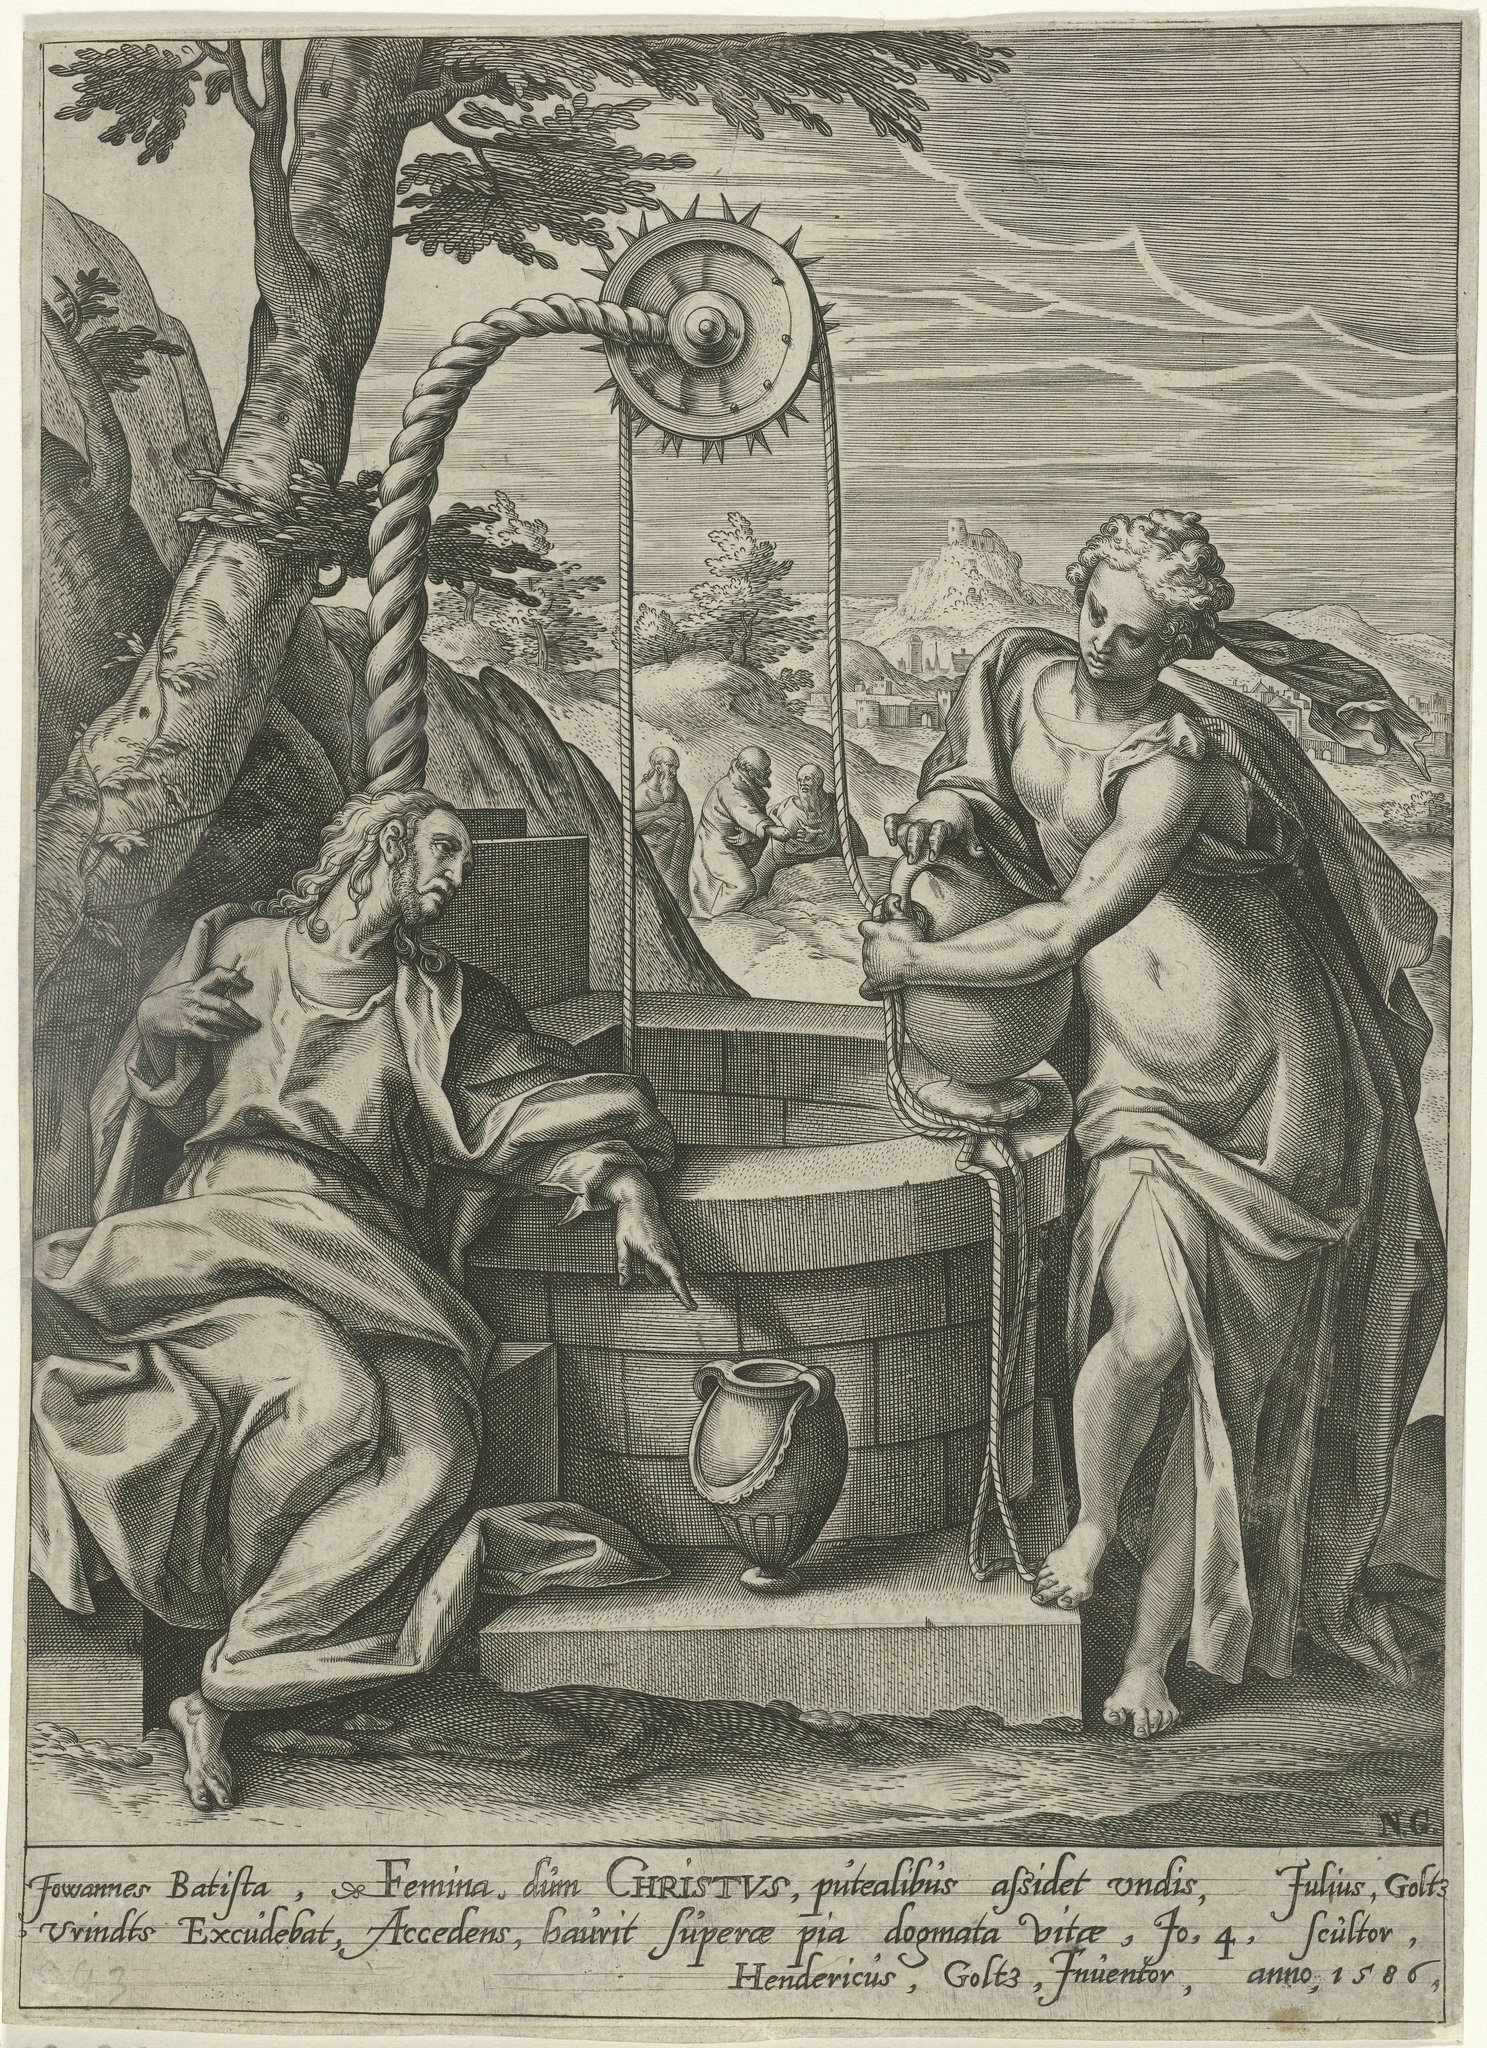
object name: print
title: Christus en de Samaritaanse vrouw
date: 1586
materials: paper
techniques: engraving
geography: antwerp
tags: christ and the woman of samaria: sitting at jacob's well he asks her for a drink from her jug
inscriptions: collector's mark: Lugt 1967, collector's mark: Lugt 2228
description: Christus zit op de grond bij een bron en is in gesprek met een Samaritaanse vrouw. Hij vraagt haar om wat water uit haar kruik. De apostelen in de achtergrond (Johannes 4:1-30). De prent heeft een Latijns onderschrift.